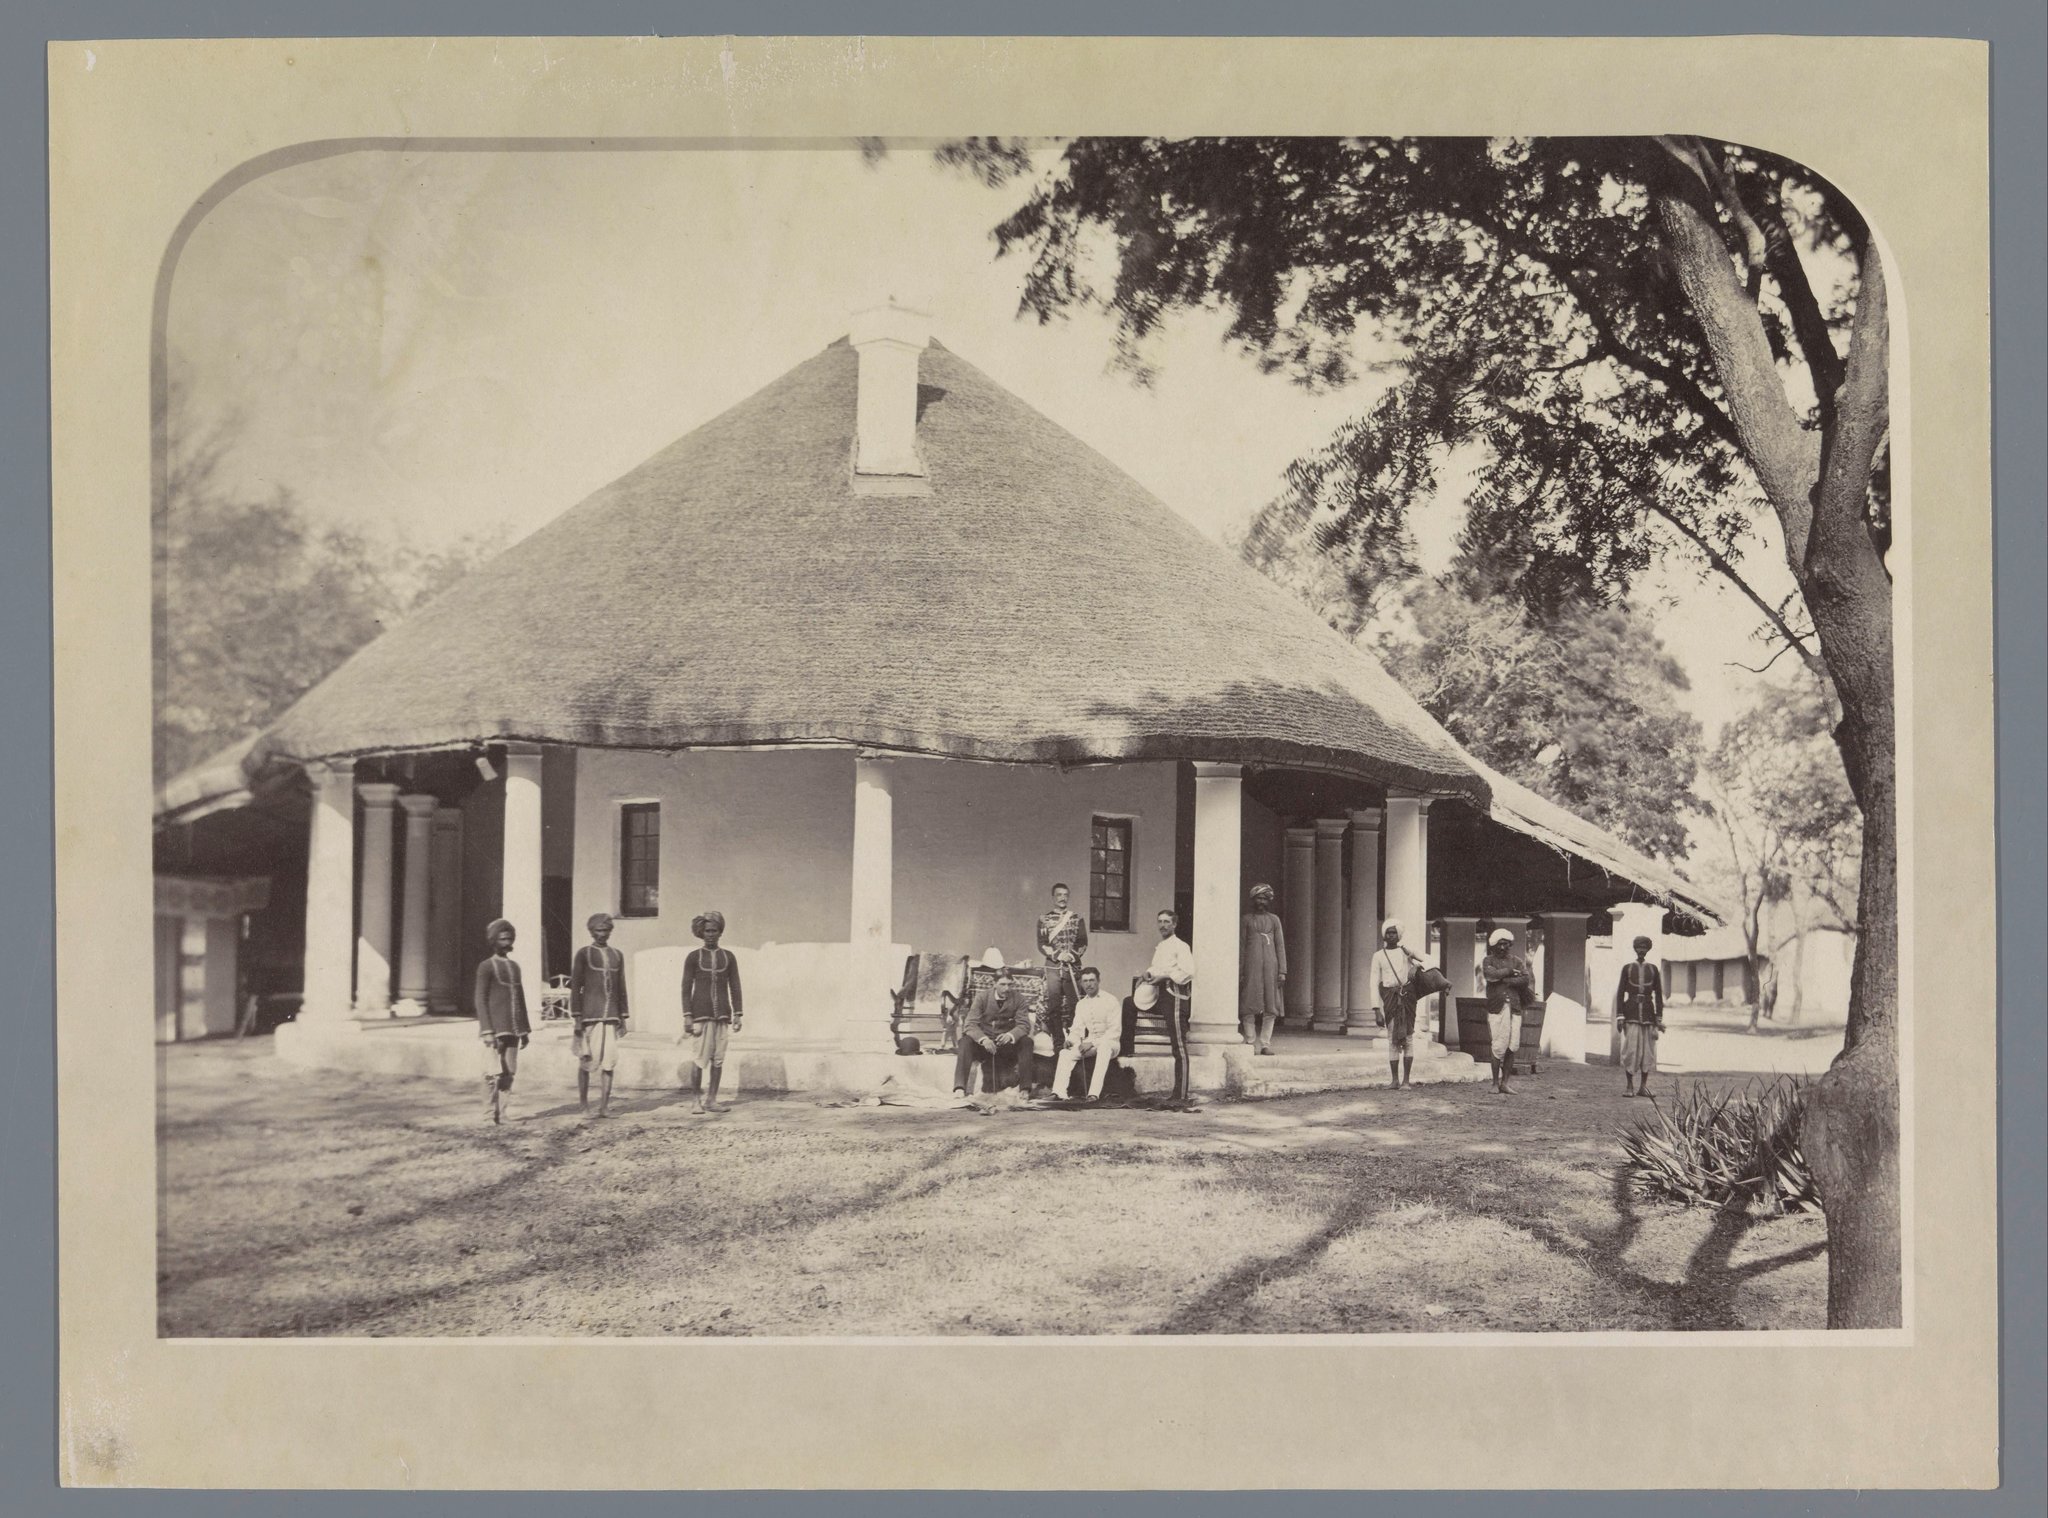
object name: photograph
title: View of a house with British military officials and Indian servants, possibly in Afghanistan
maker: j.n.o. burke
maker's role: fotograaf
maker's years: 1843-1900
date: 1878-1890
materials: paper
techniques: albumen print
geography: afghanistan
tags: colonial system